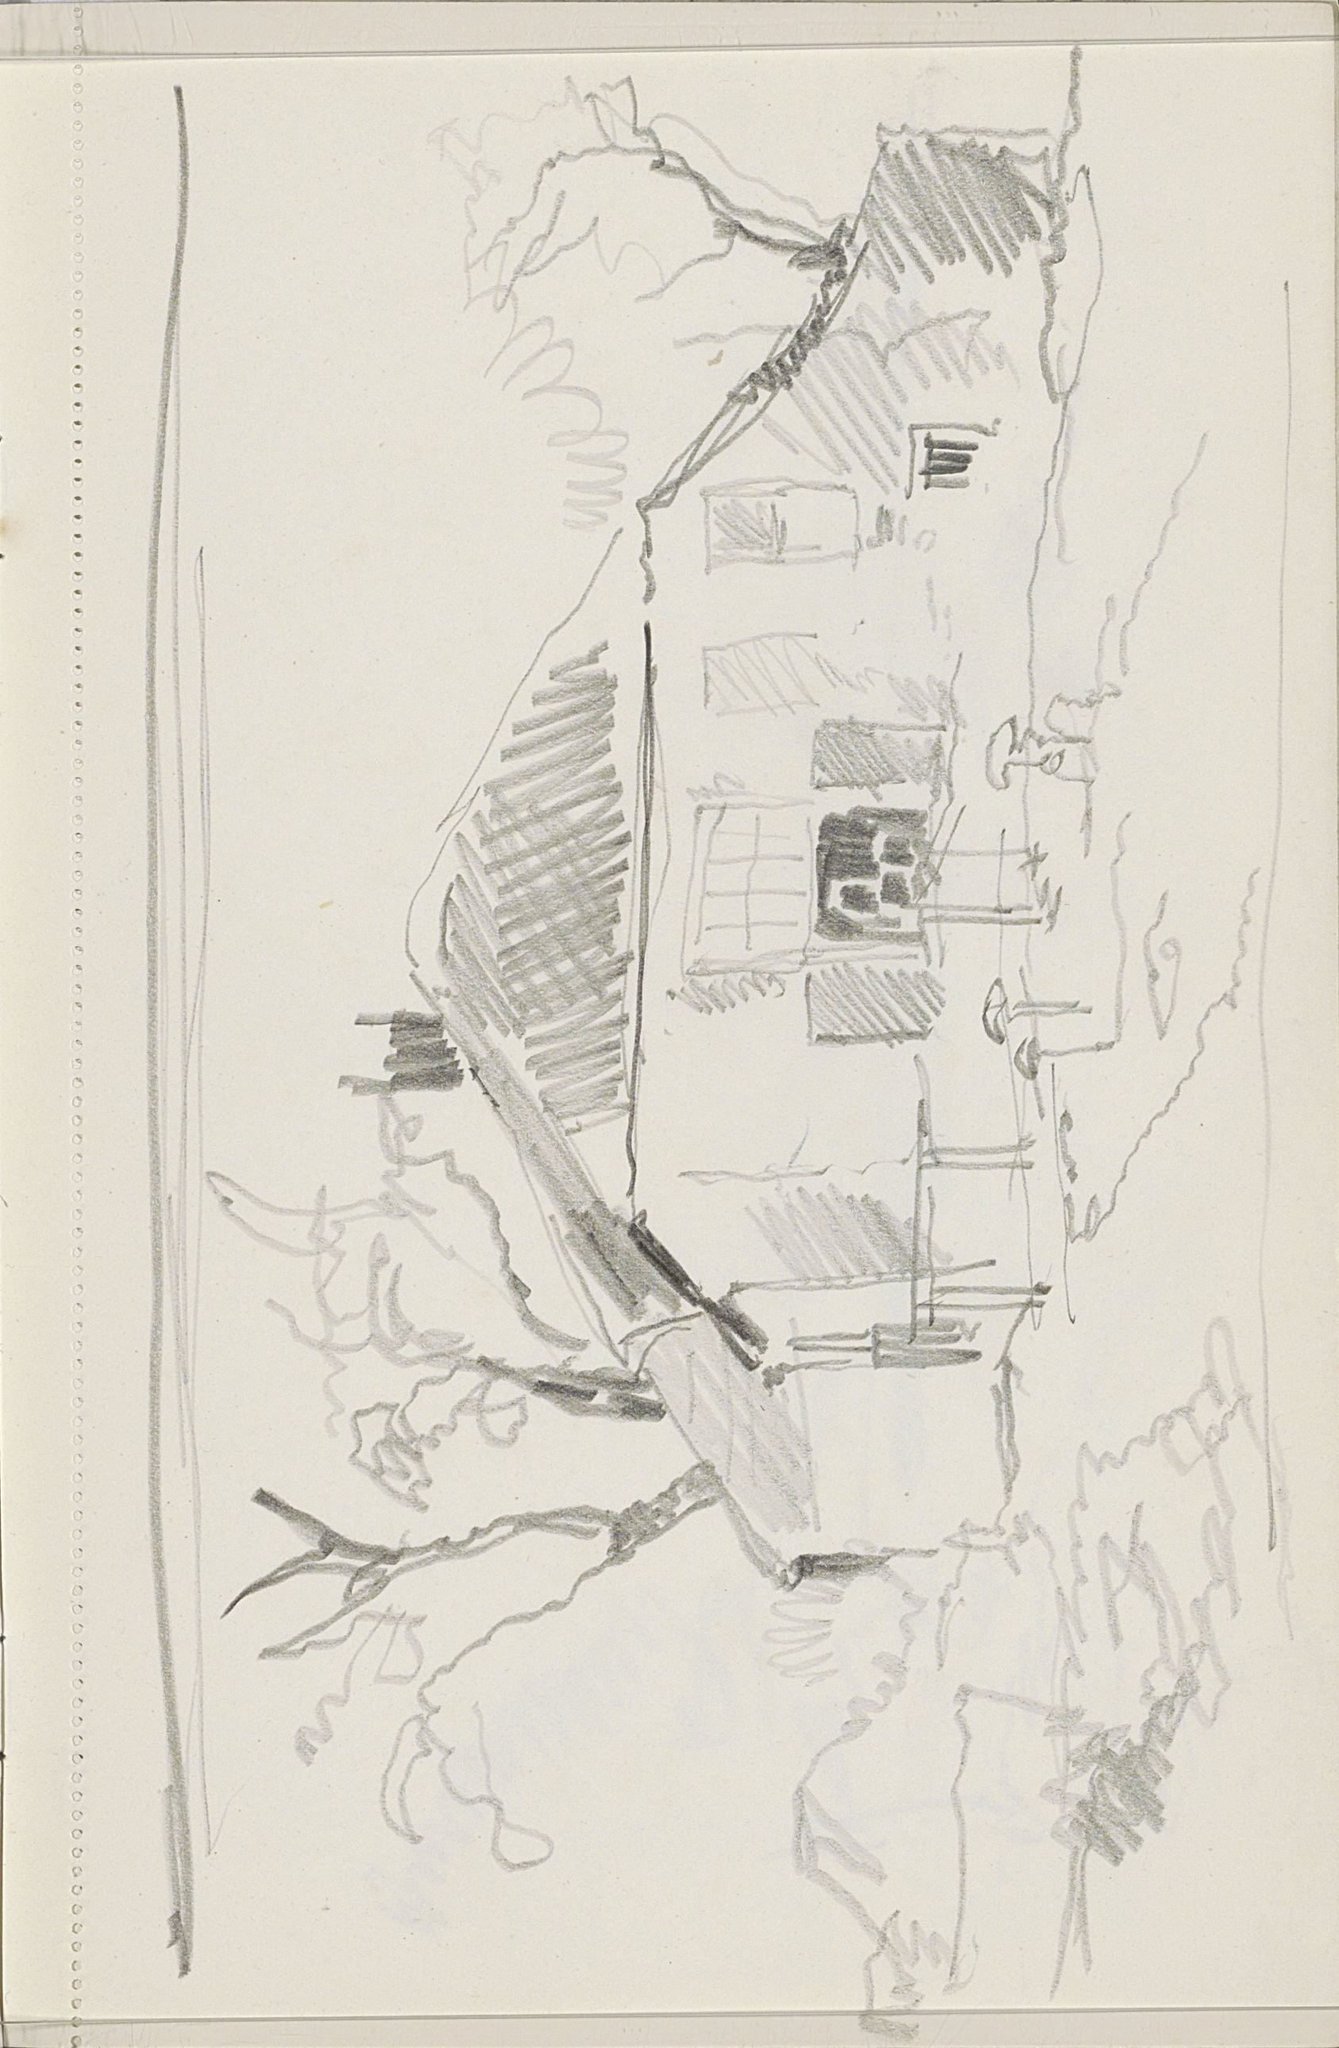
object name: sketchbook leaf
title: Boerderij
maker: cornelis vreedenburgh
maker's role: draughtsman, print maker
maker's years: 1880-1946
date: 1935-1936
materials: paper, pencil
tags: farm (building)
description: Blad 12 recto uit een schetsboek met 73 bladen.